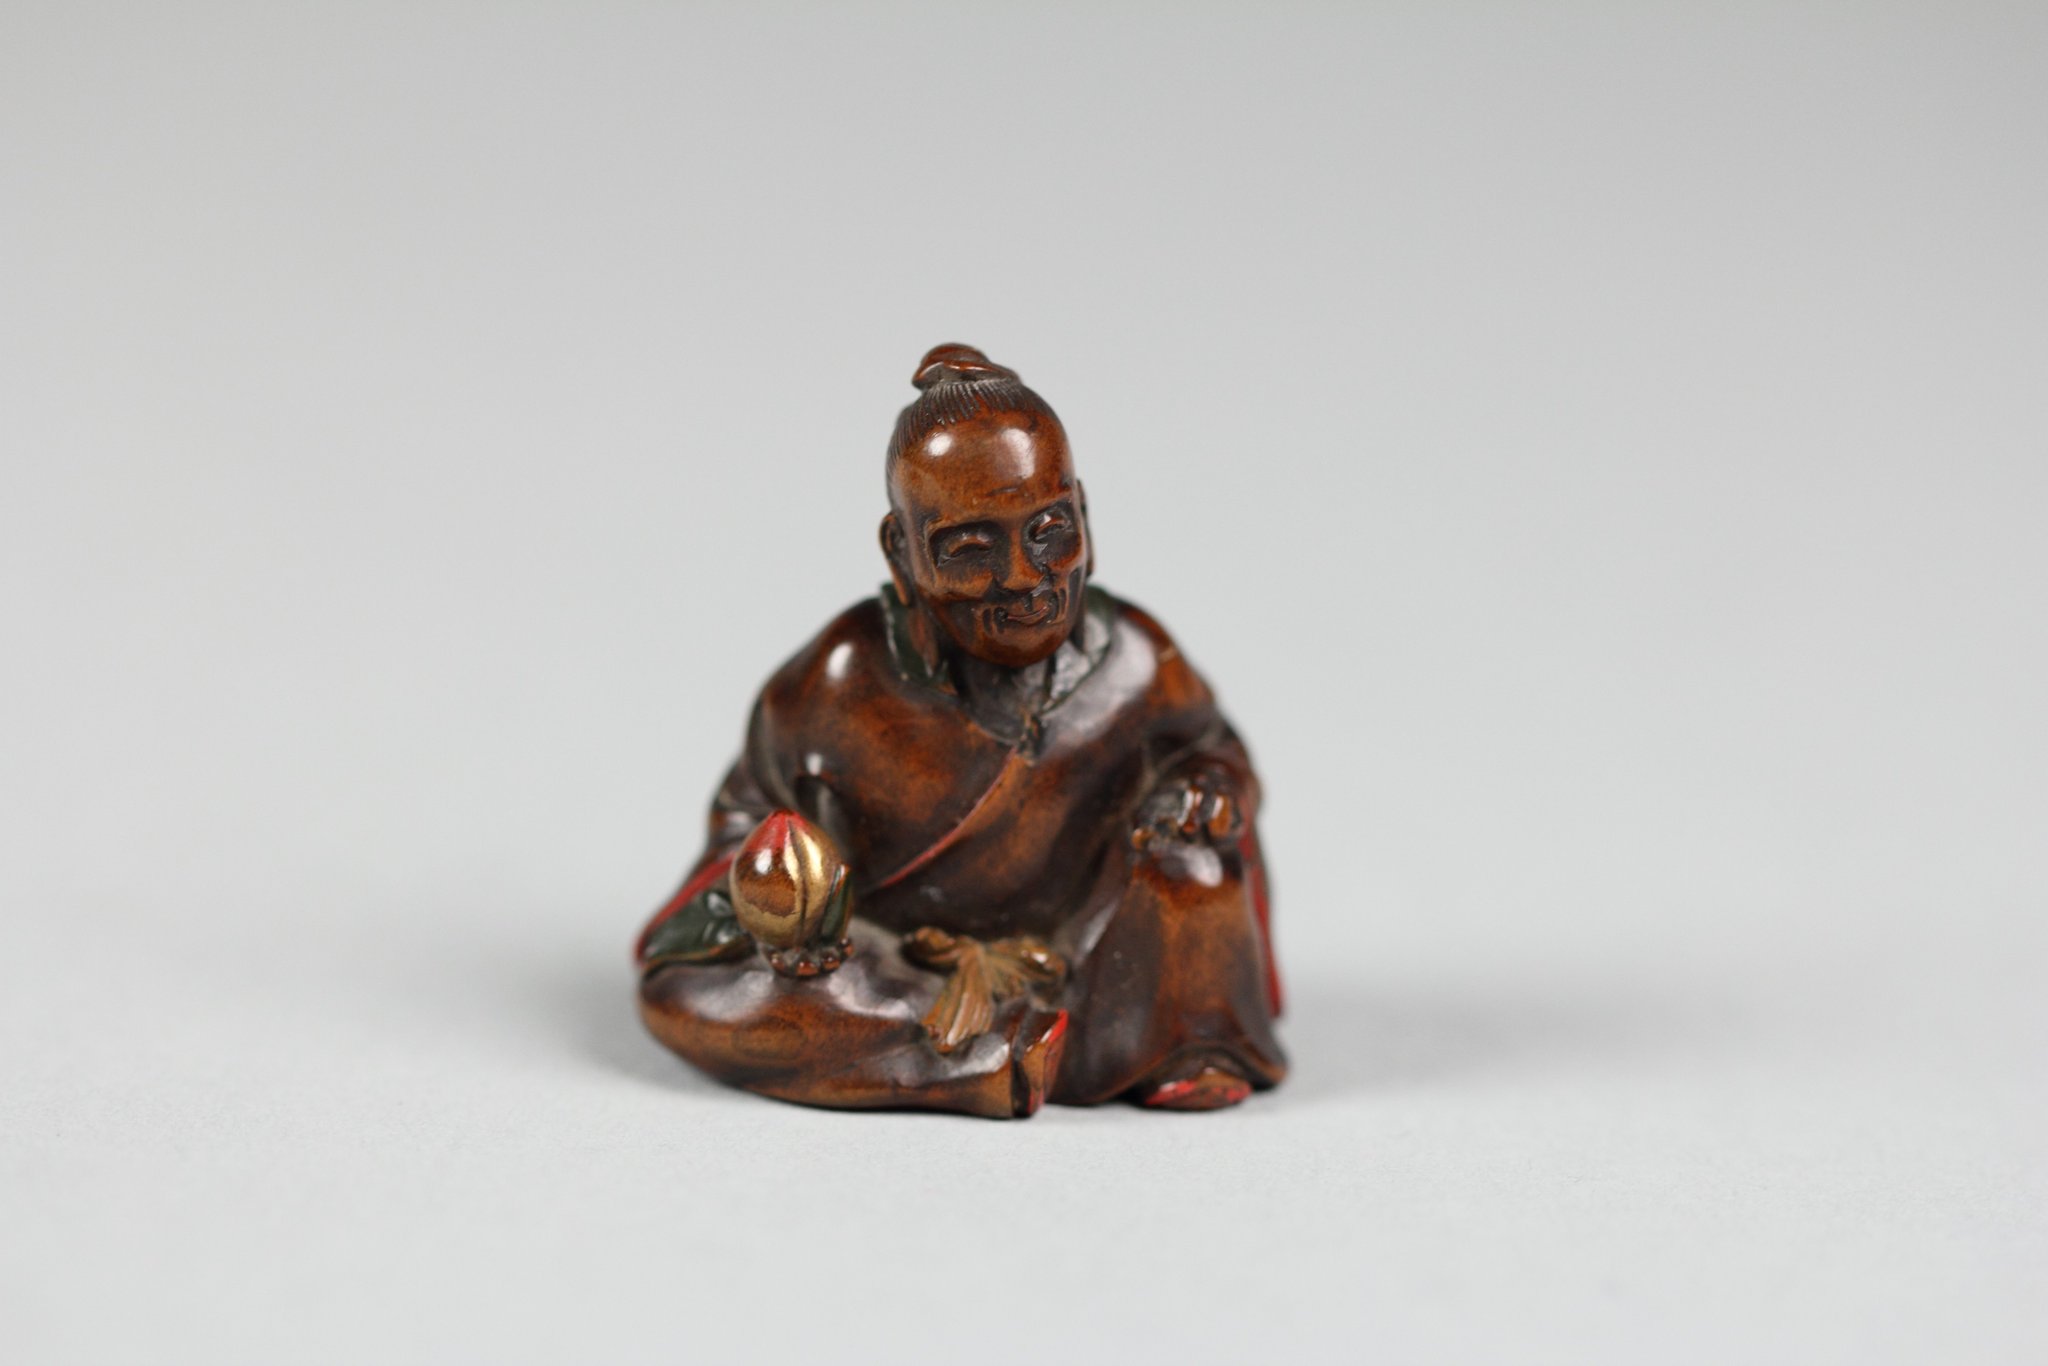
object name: netsuke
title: God of Longevity with a Peach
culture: japanese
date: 1801-1900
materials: wood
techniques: stain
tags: peaches